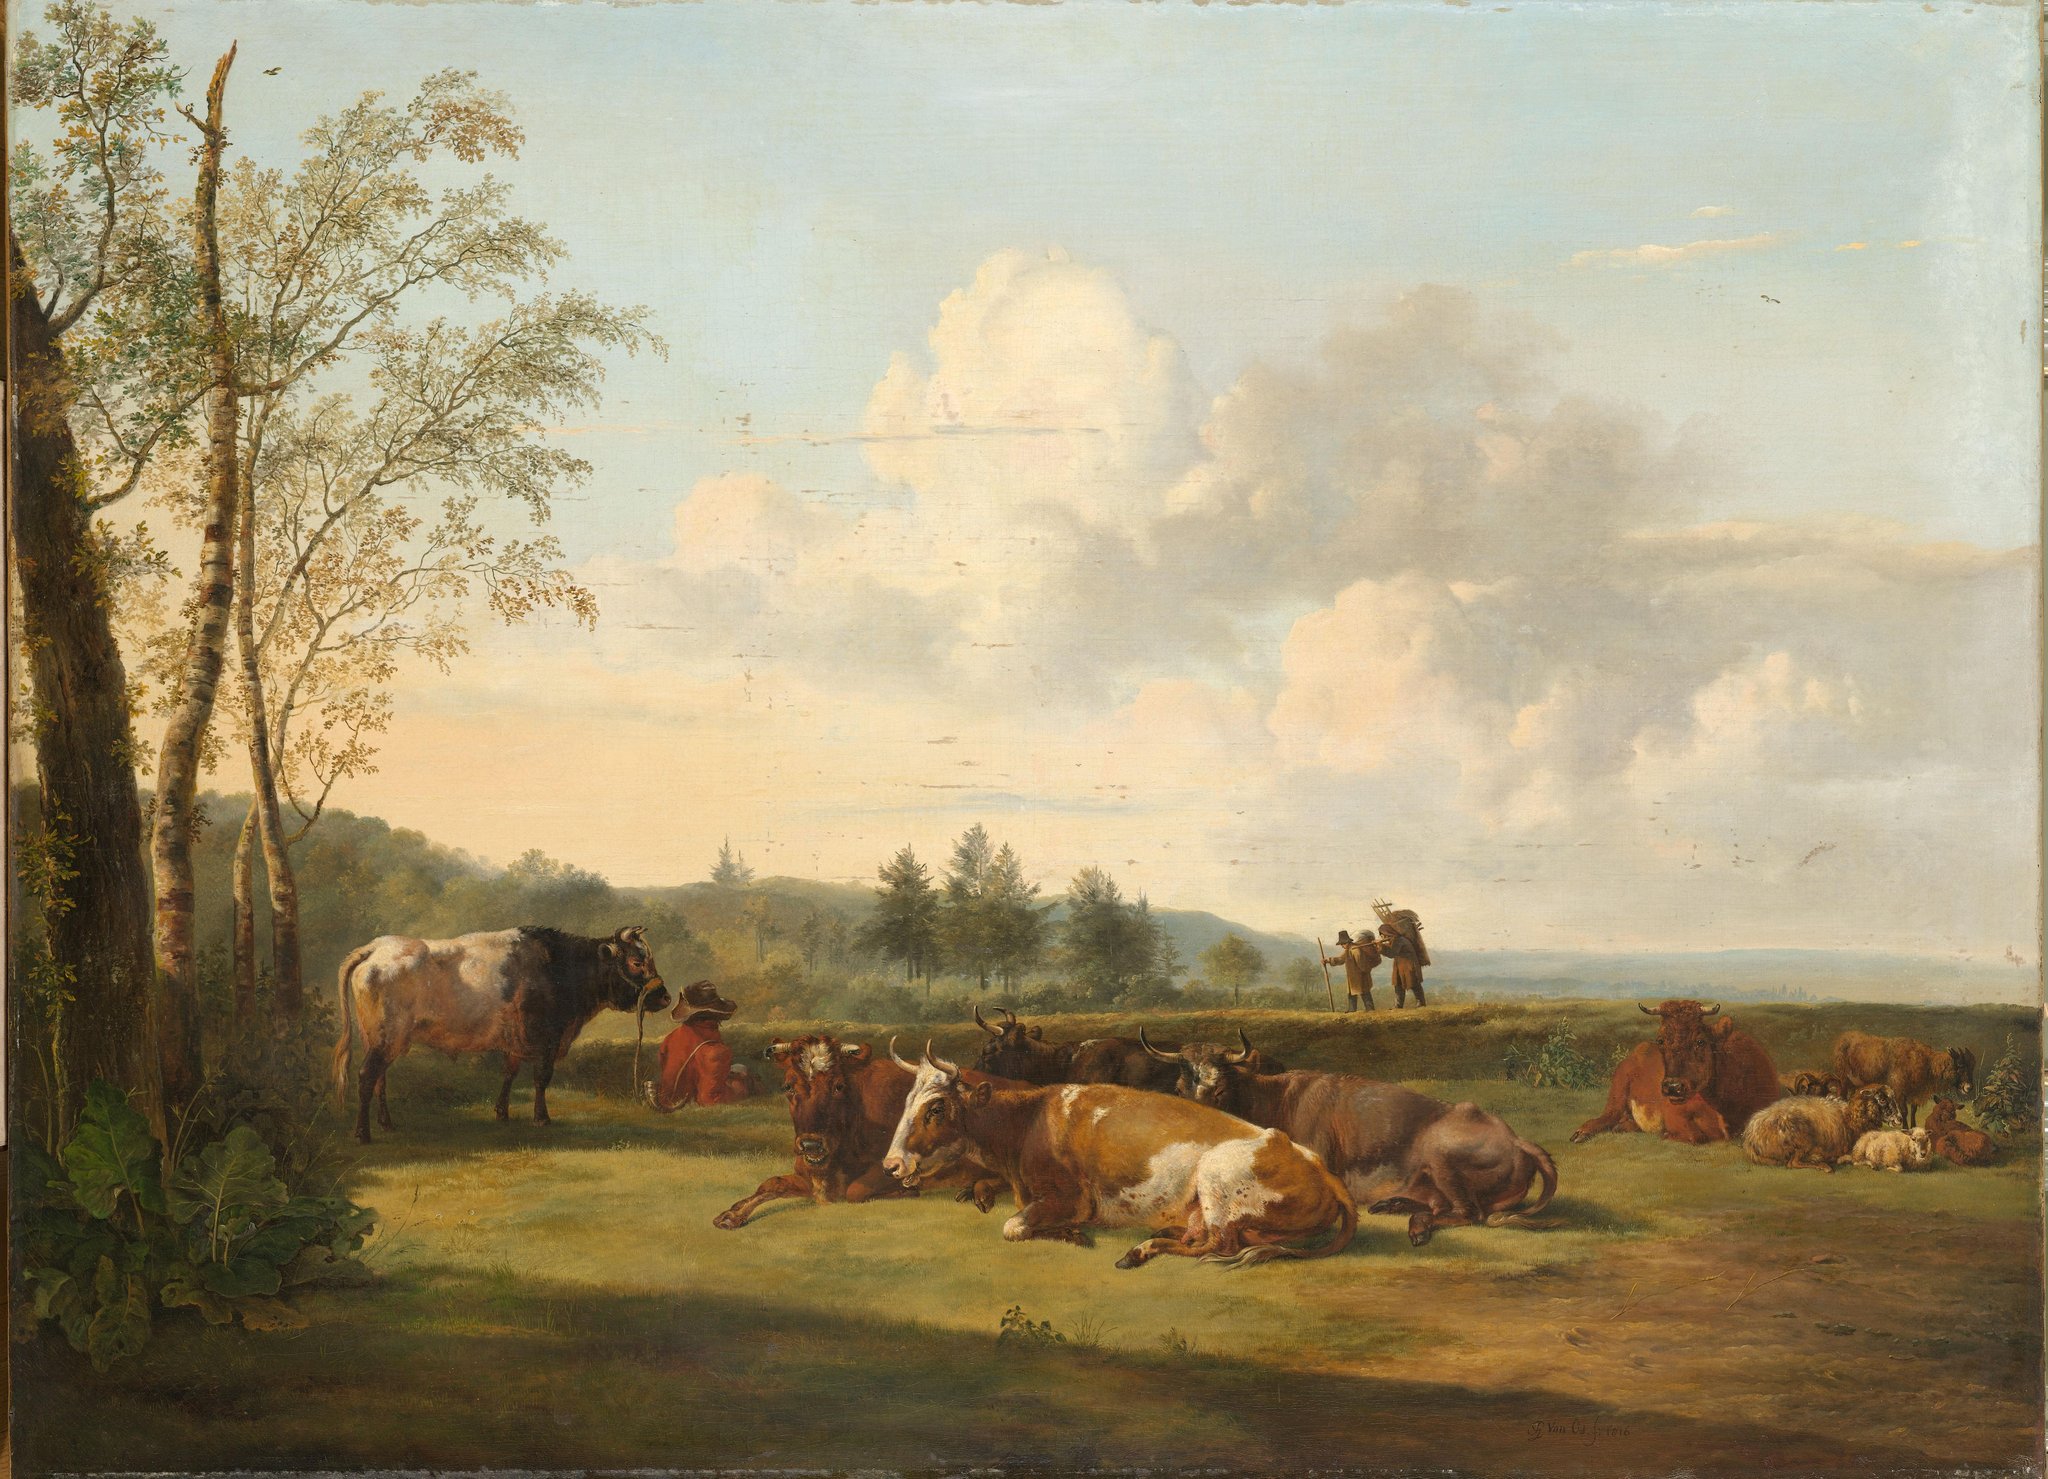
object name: painting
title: Landscape with Cattle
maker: pieter gerardus van os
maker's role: draughtsman, painter, print maker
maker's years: 1776-1839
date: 1816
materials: canvas, oil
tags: meadow, pasture, bovine cattle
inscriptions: signature and date: ‘PG van Os ft. 1816’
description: Landschap met vee. Weide met liggende koeien en schapen. Links zit een herder met een stier aan een lijn. Over een weg komen twee reizigers aangelopen.